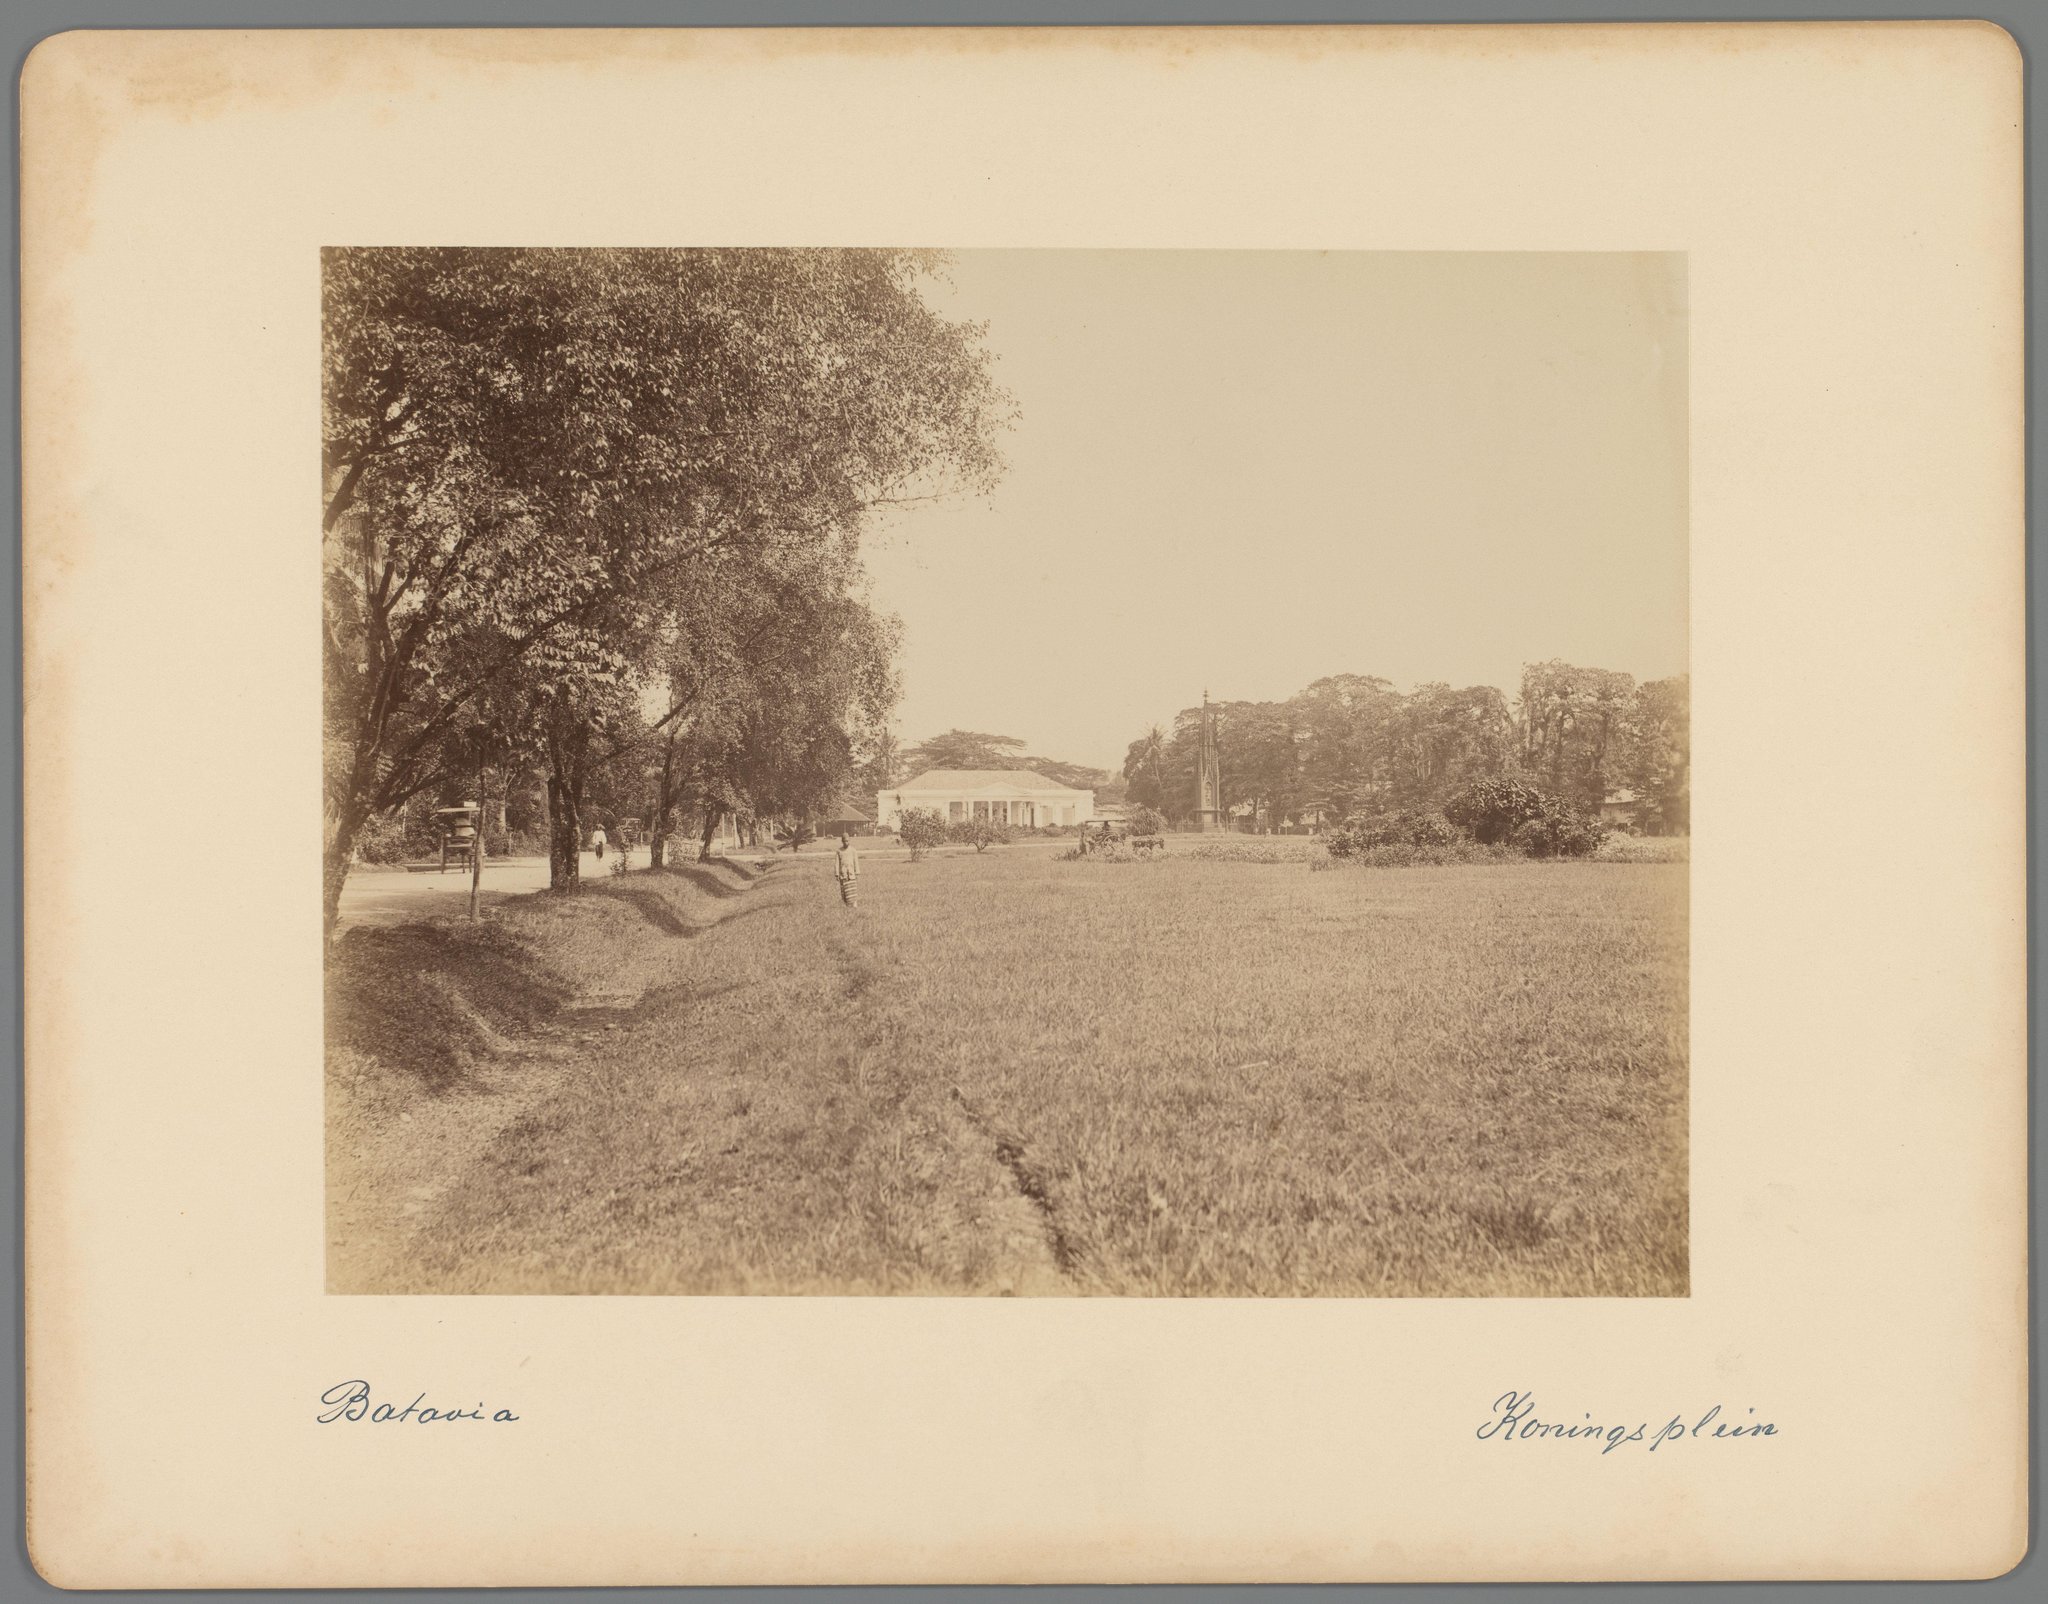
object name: photograph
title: Gezicht op het Koningsplein, Batavia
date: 1880-1895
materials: cardboard, paper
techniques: albumen print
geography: batavia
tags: square, place, circus, etc.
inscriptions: inscription: ‘Foto’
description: Deze foto zat oorspronkelijk in prentenkabinet RP-F-AA3192.